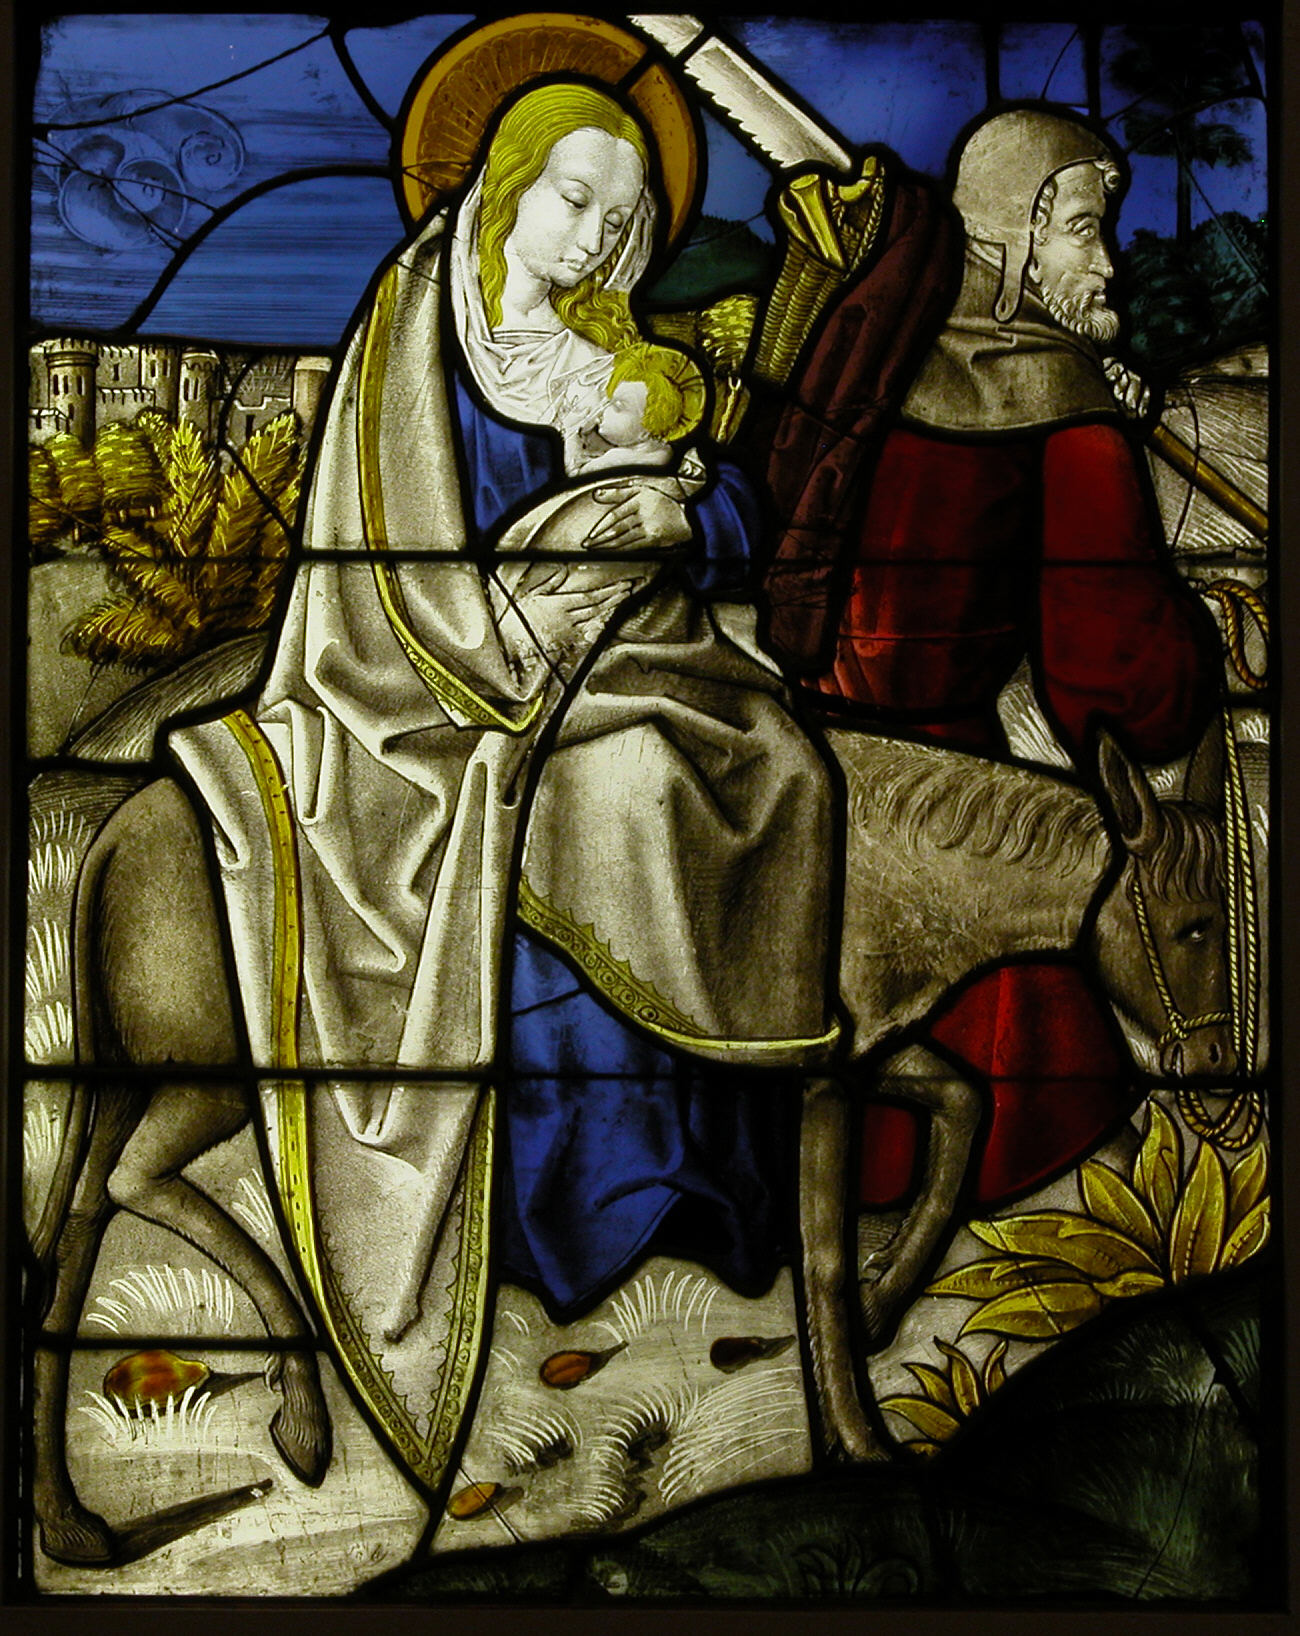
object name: panel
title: Stained Glass Panel with the Flight into Egypt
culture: german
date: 1485-1500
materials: glass, metal, paint, pigment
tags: donkeys,holy family